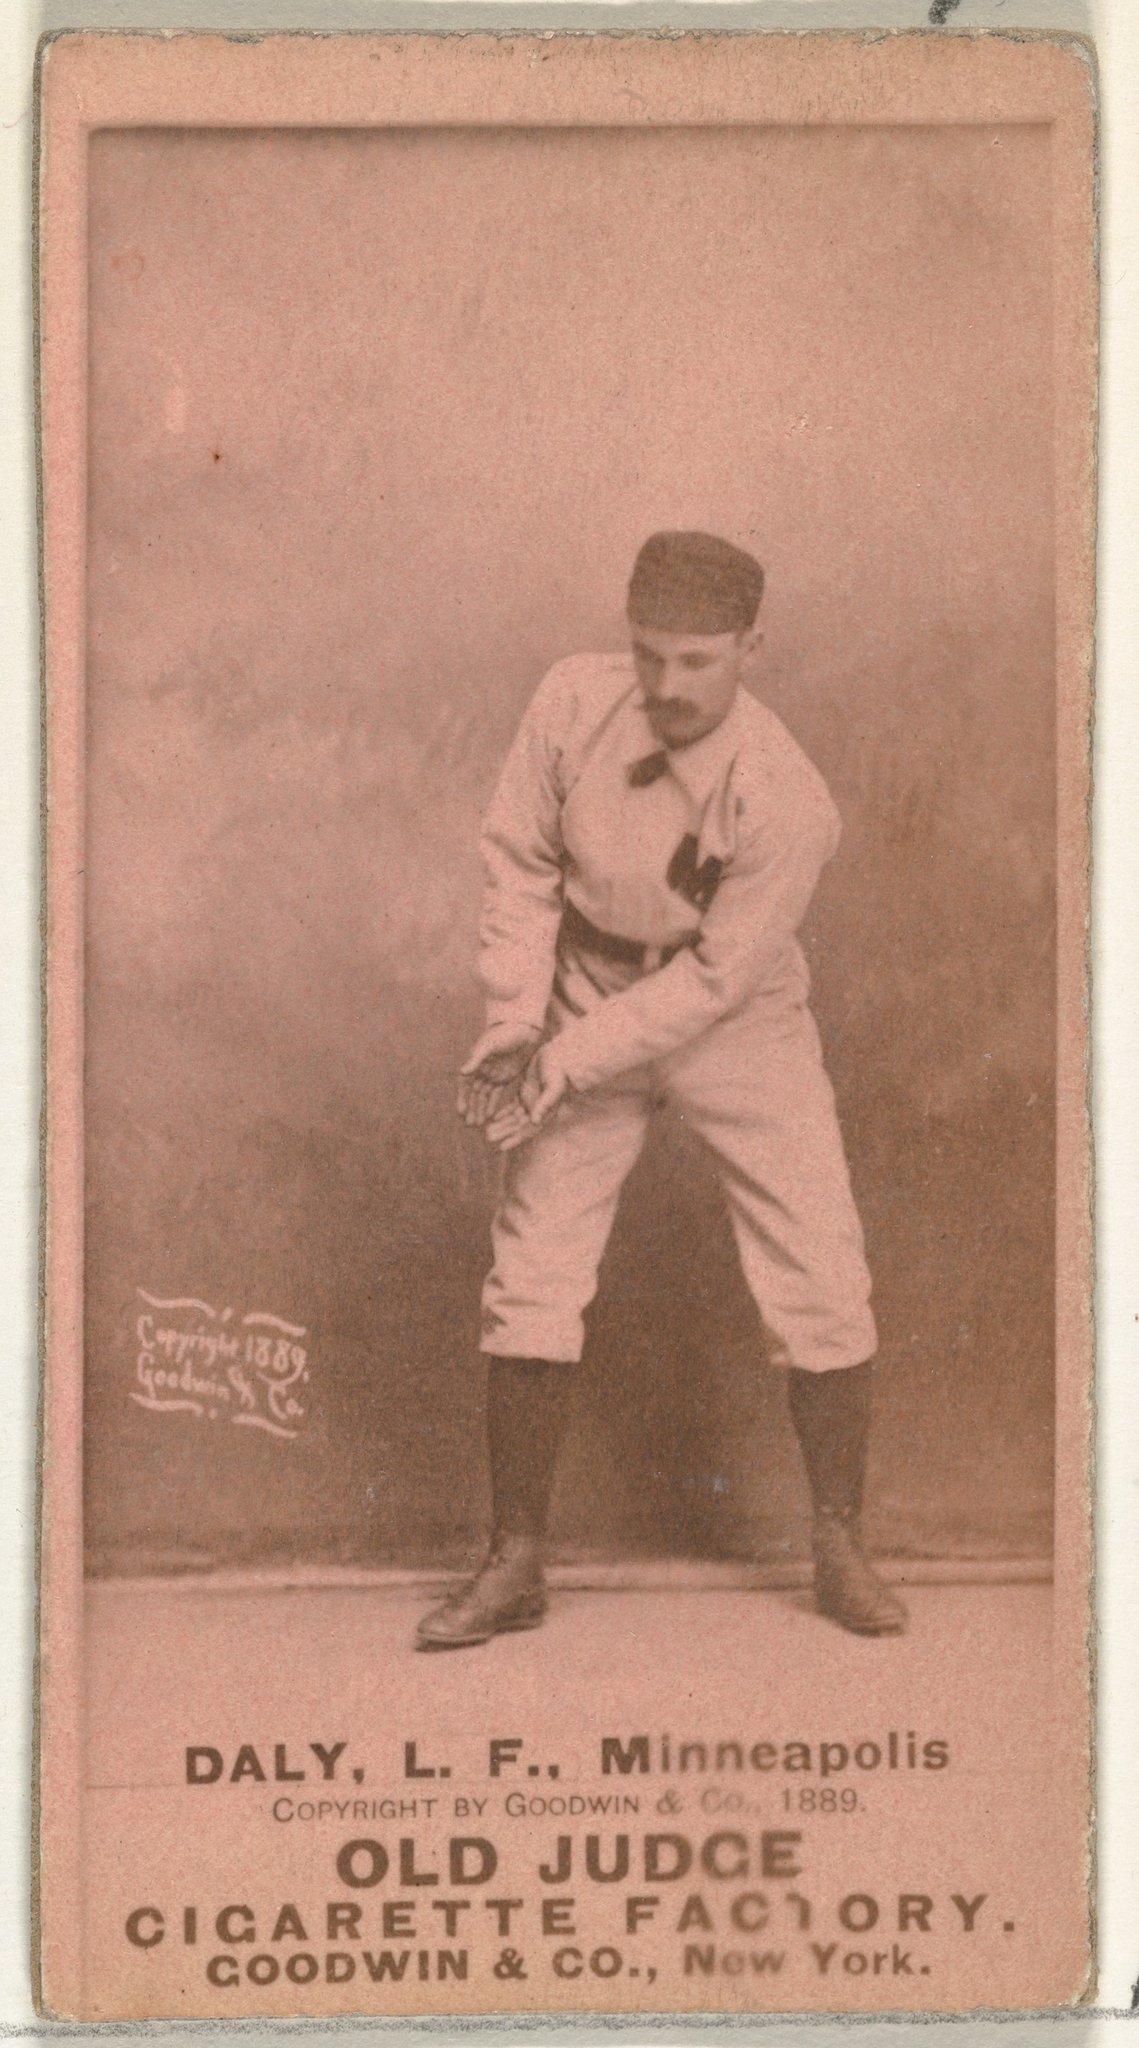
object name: baseball card, photograph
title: James J. "Sun" Daly, Left Field, Minneapolis, from the Old Judge series (N172) for Old Judge Cigarettes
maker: goodwin & company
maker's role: publisher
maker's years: 1850-1950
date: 1889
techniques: albumen silver print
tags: men,portraits,baseball,athletes